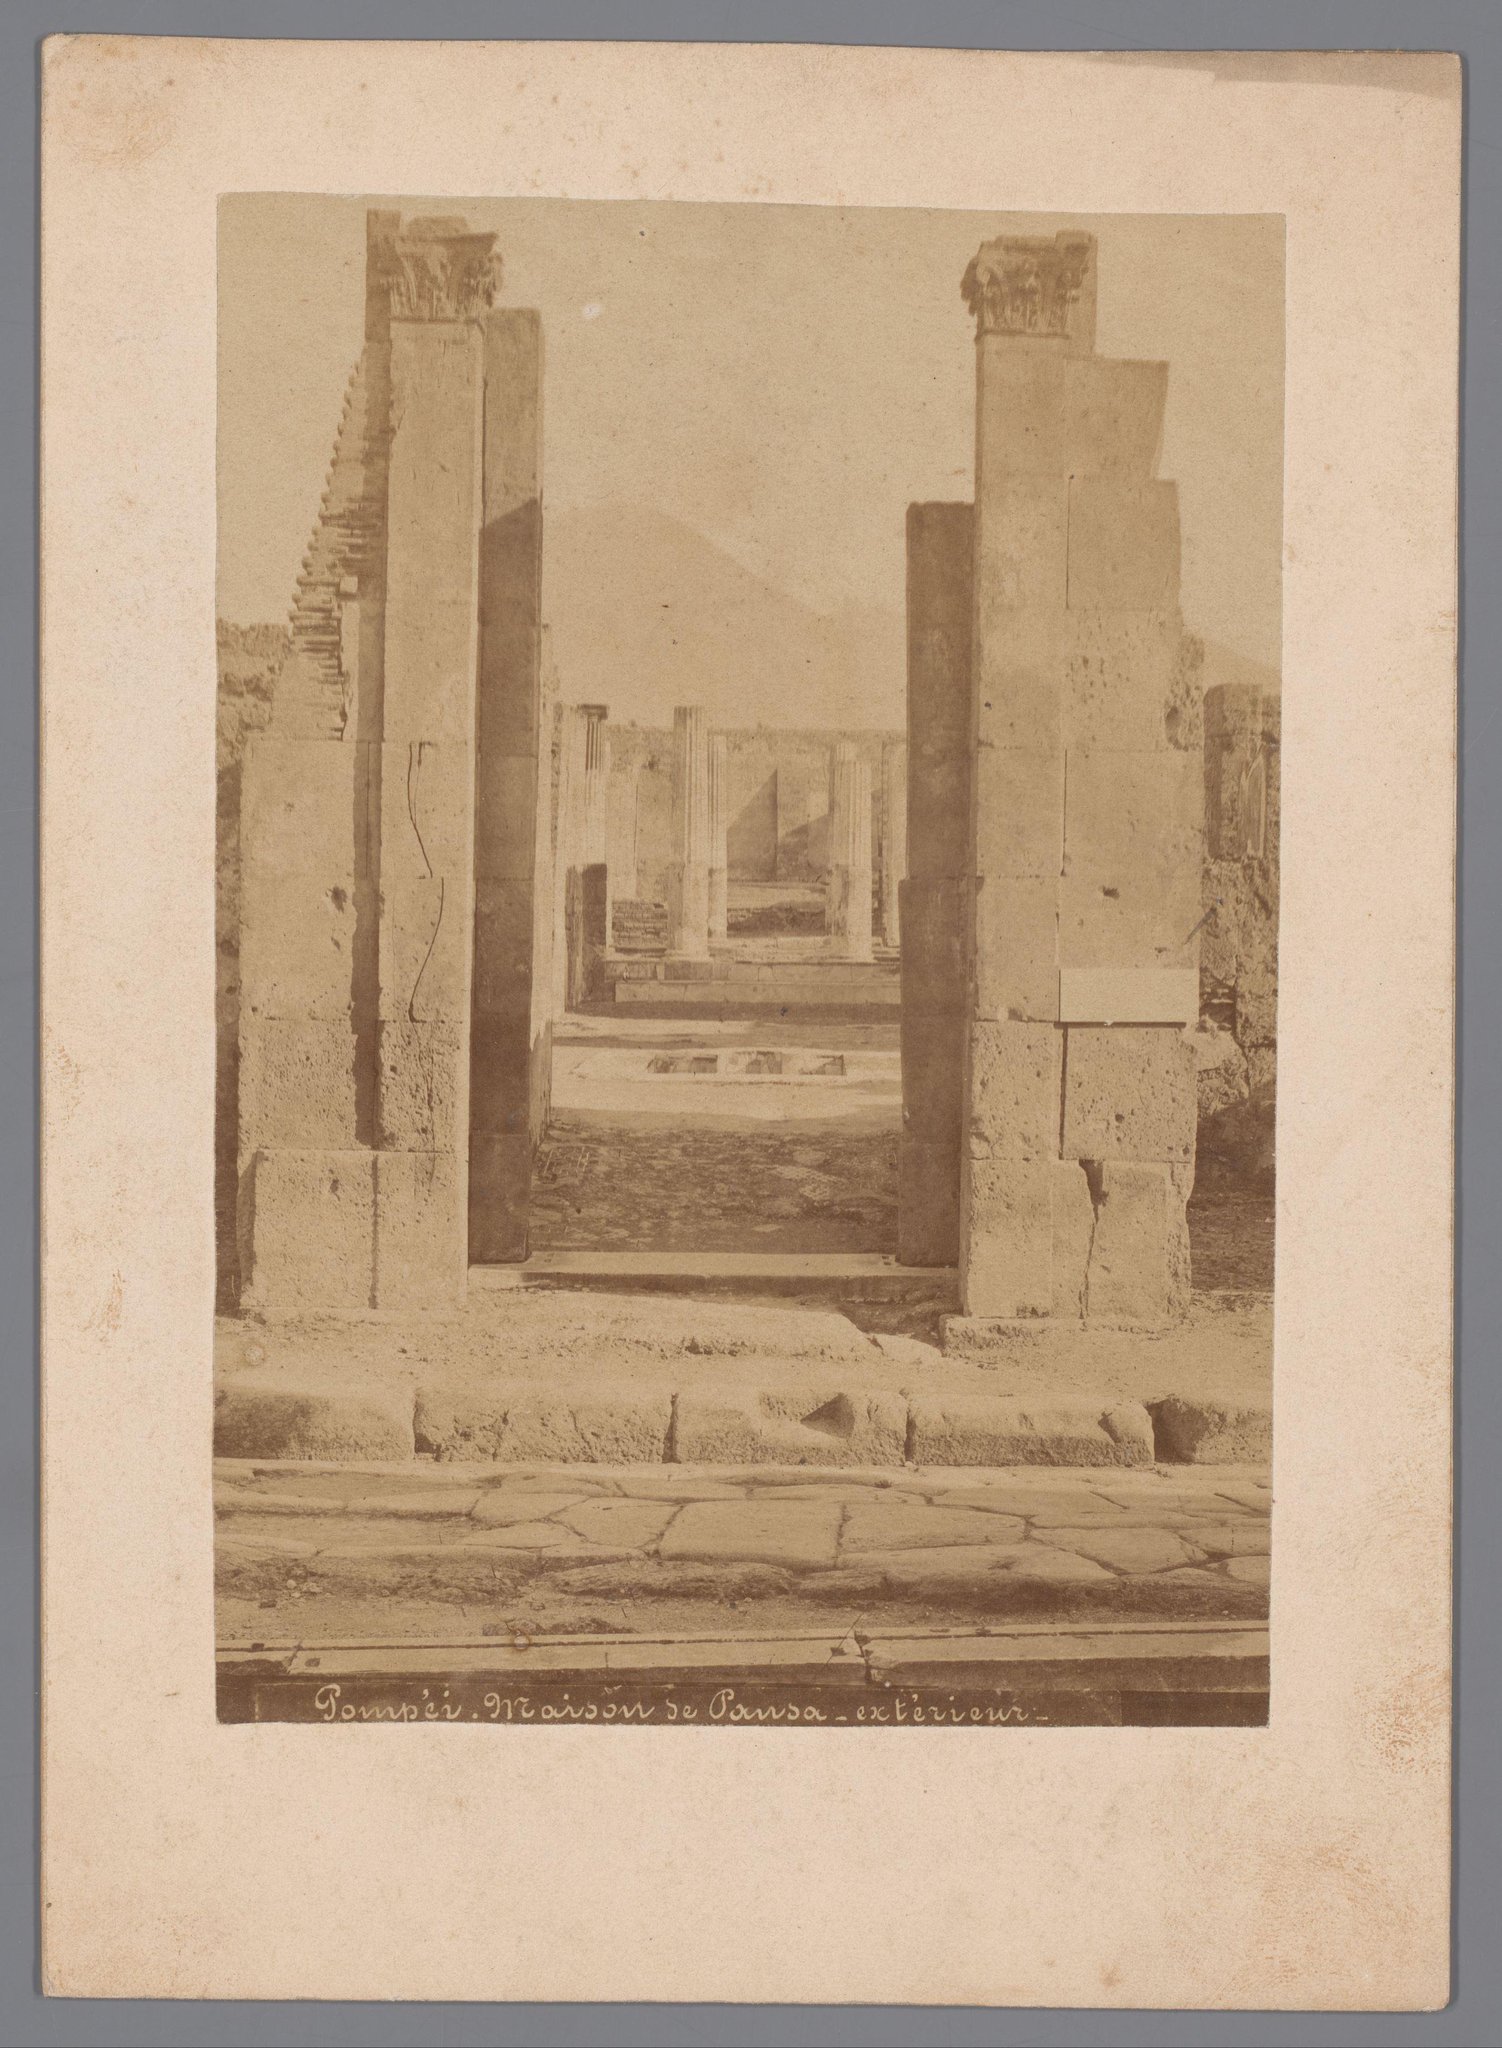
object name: photograph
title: Pompéi. Maison de Pansa - extérieur -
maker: giorgio sommer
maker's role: fotograaf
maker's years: 1834-1914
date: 1857-1914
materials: cardboard, paper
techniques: albumen print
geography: pompeii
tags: urban housing, ruin of a building ~ architecture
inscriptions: collector's mark: ‘VOSMAER’